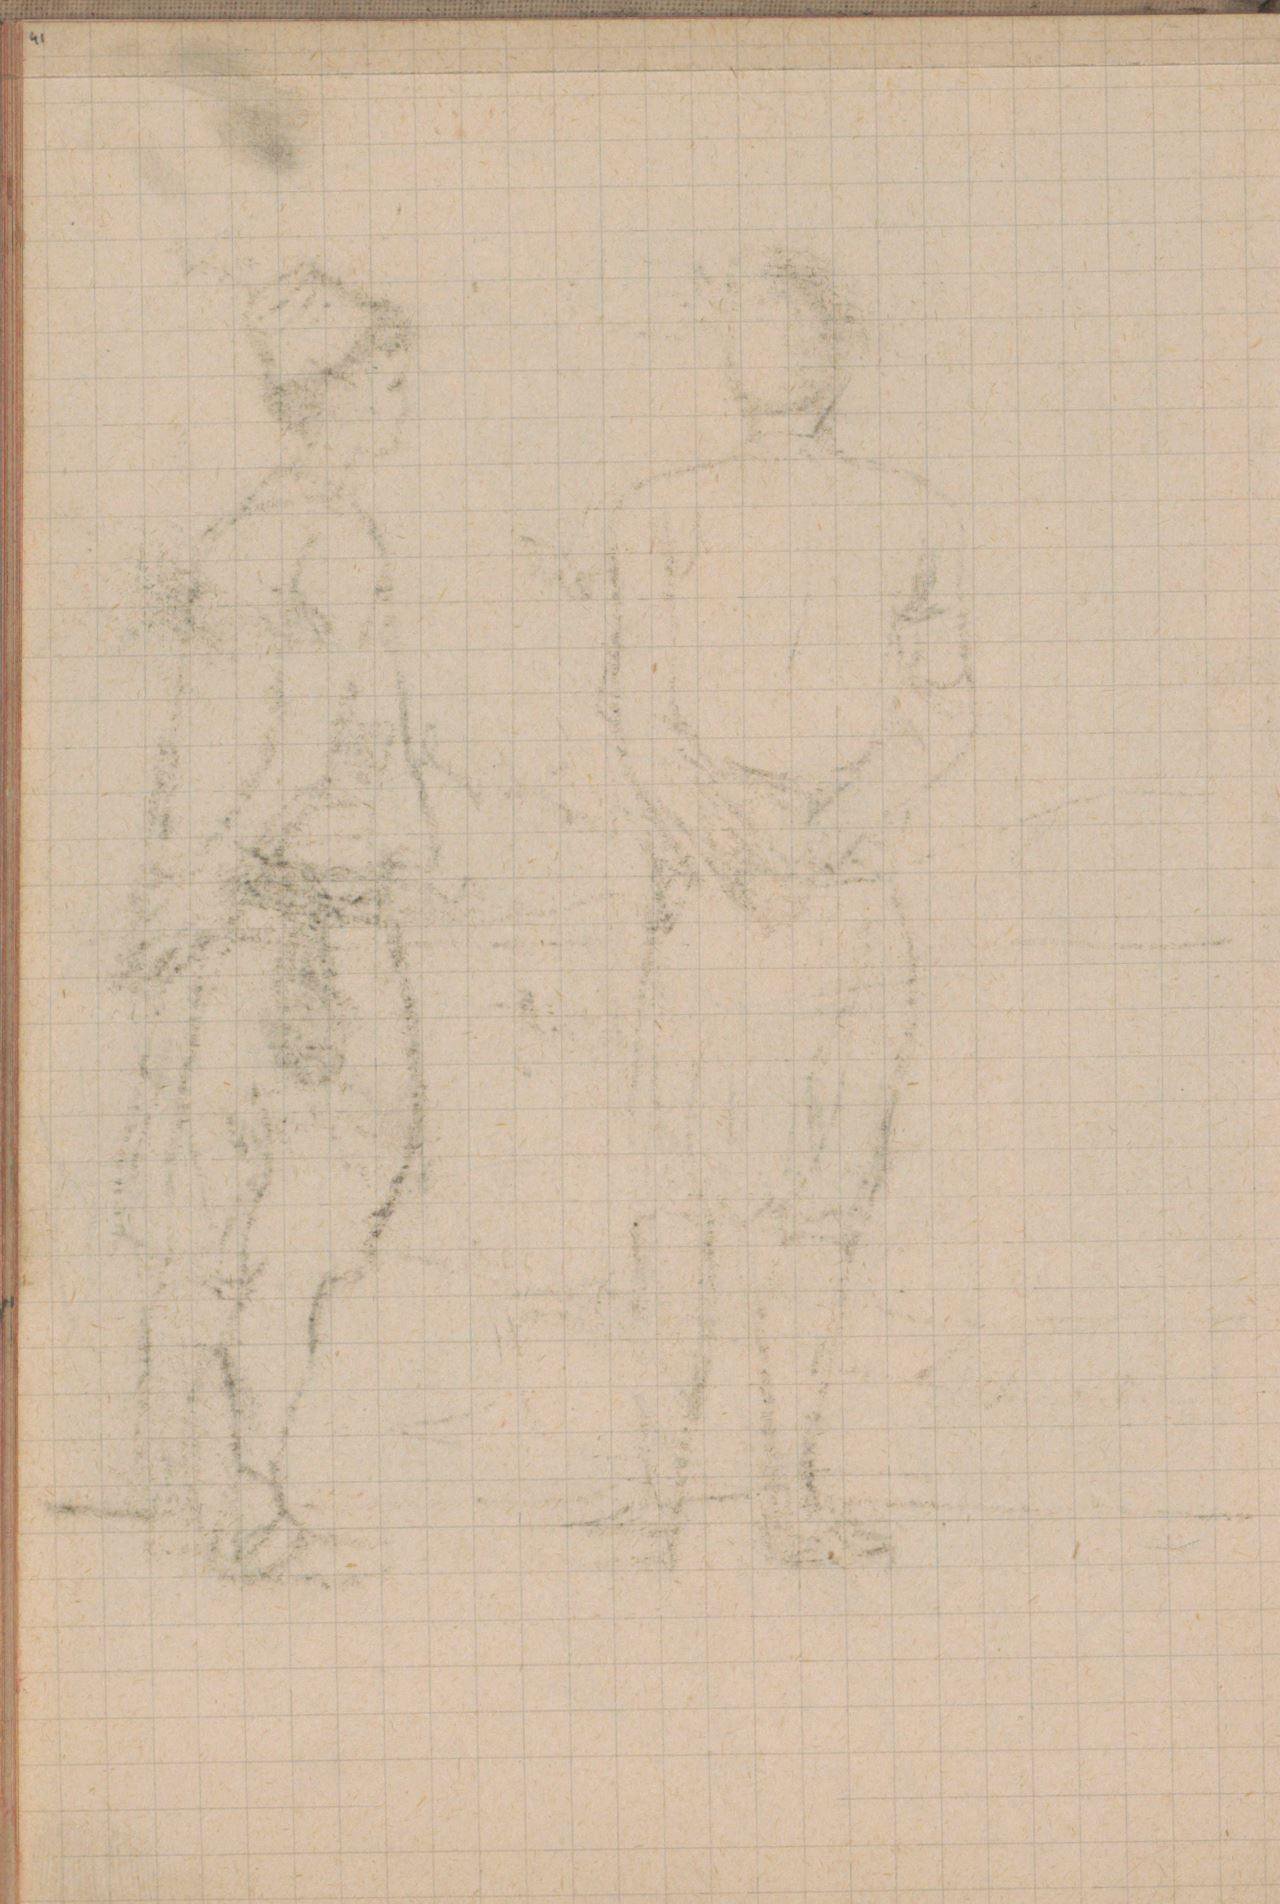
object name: sketchbook leaf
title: Abklatsch van de krijttekening op pagina 42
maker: marius bauer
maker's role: draughtsman, print maker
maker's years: 1867-1932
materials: paper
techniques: printmaking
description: Pagina 41 uit een schetsboek met 51 bladen.